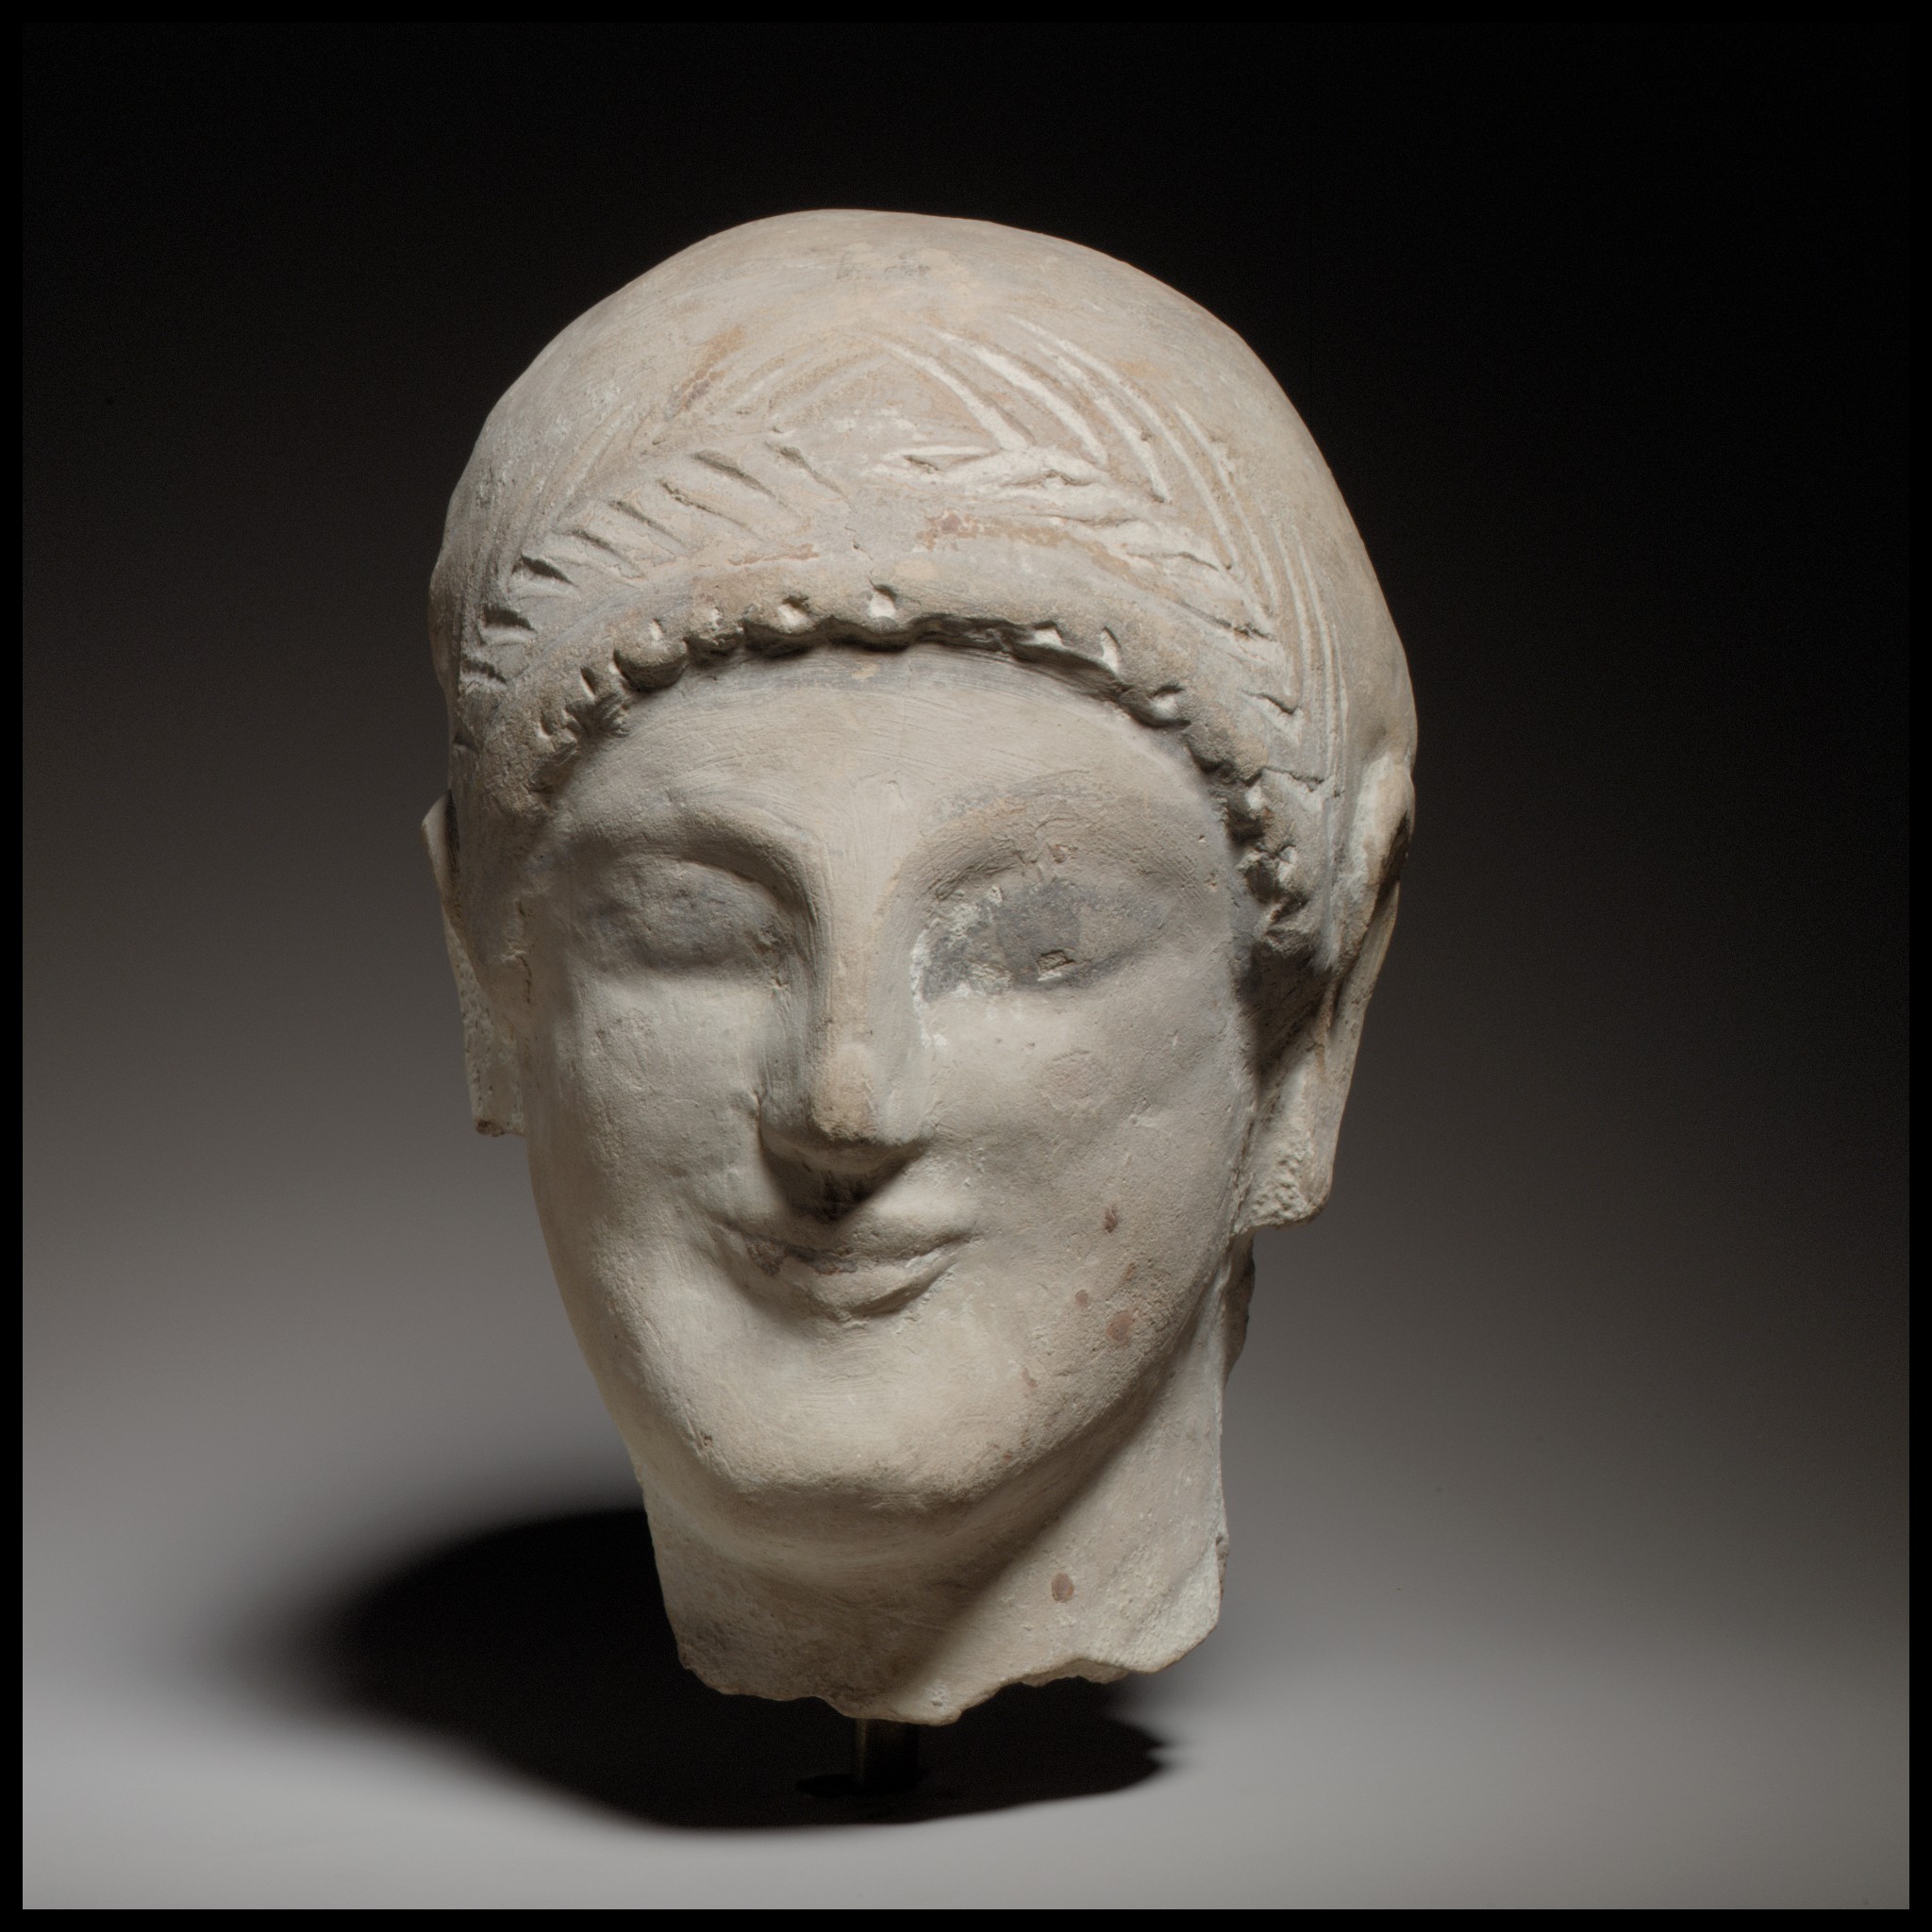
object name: head of a man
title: Male head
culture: cypriot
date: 501-600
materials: terracotta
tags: heads,men